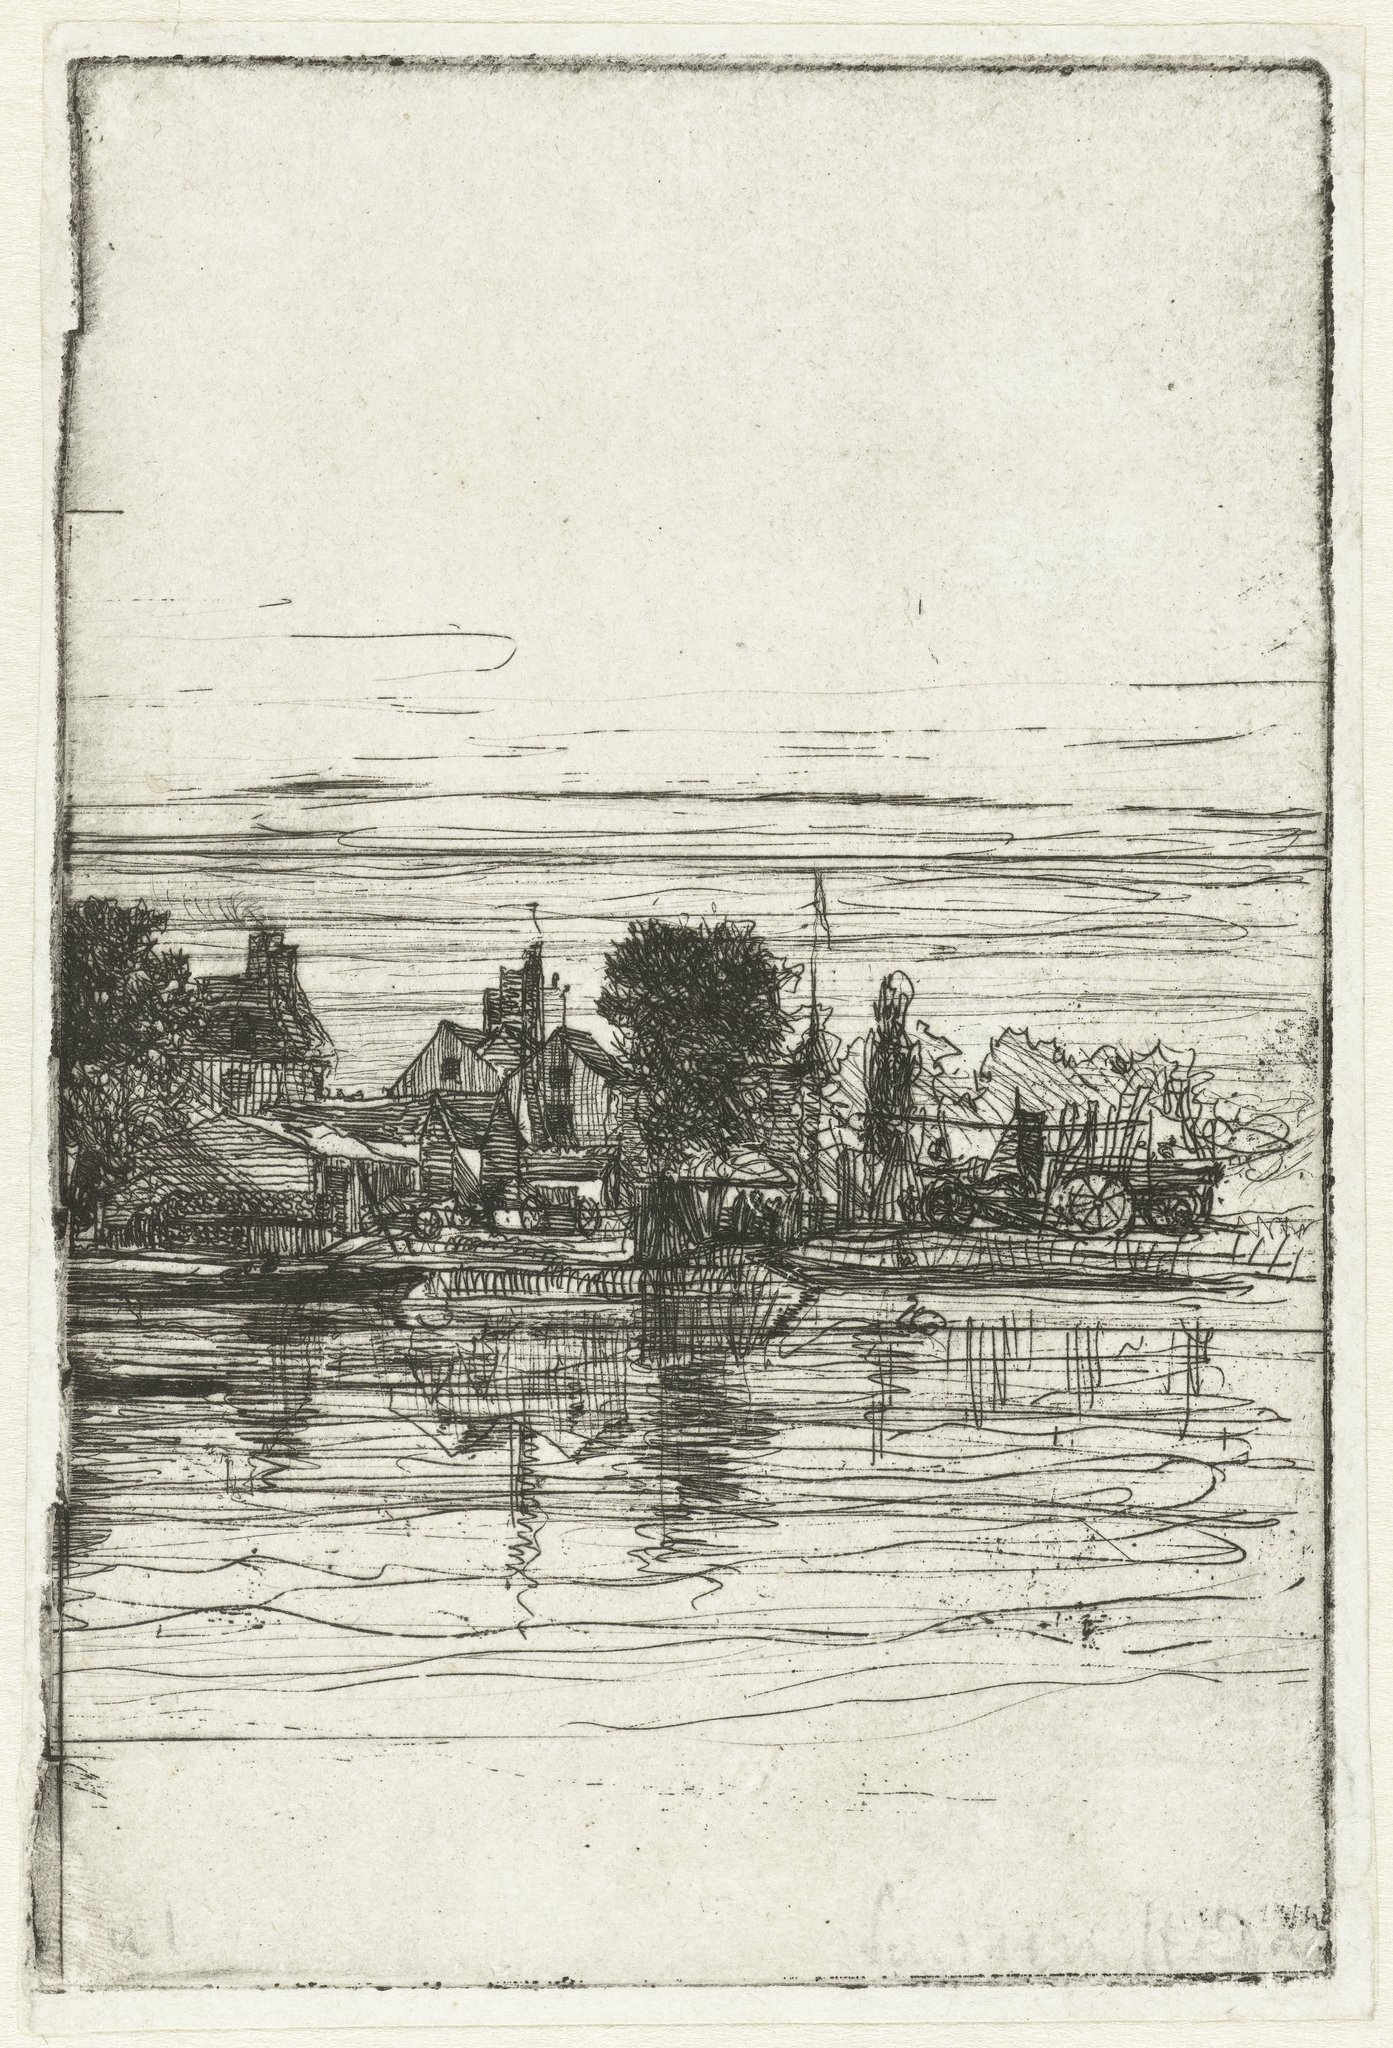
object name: print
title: Dorp aan het water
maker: francis seymour-haden (sir)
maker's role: print maker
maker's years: 1818-1910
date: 1865-1869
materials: paper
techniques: drypoint, etching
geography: england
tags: river, village, thames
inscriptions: collector's mark: Lugt 2228, signature: ‘Seymour Haden’, collector's mark: ‘L’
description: Rechterhelft van de verneden plaat van West London Rowing Club (Schneiderman 108). Botke, K.